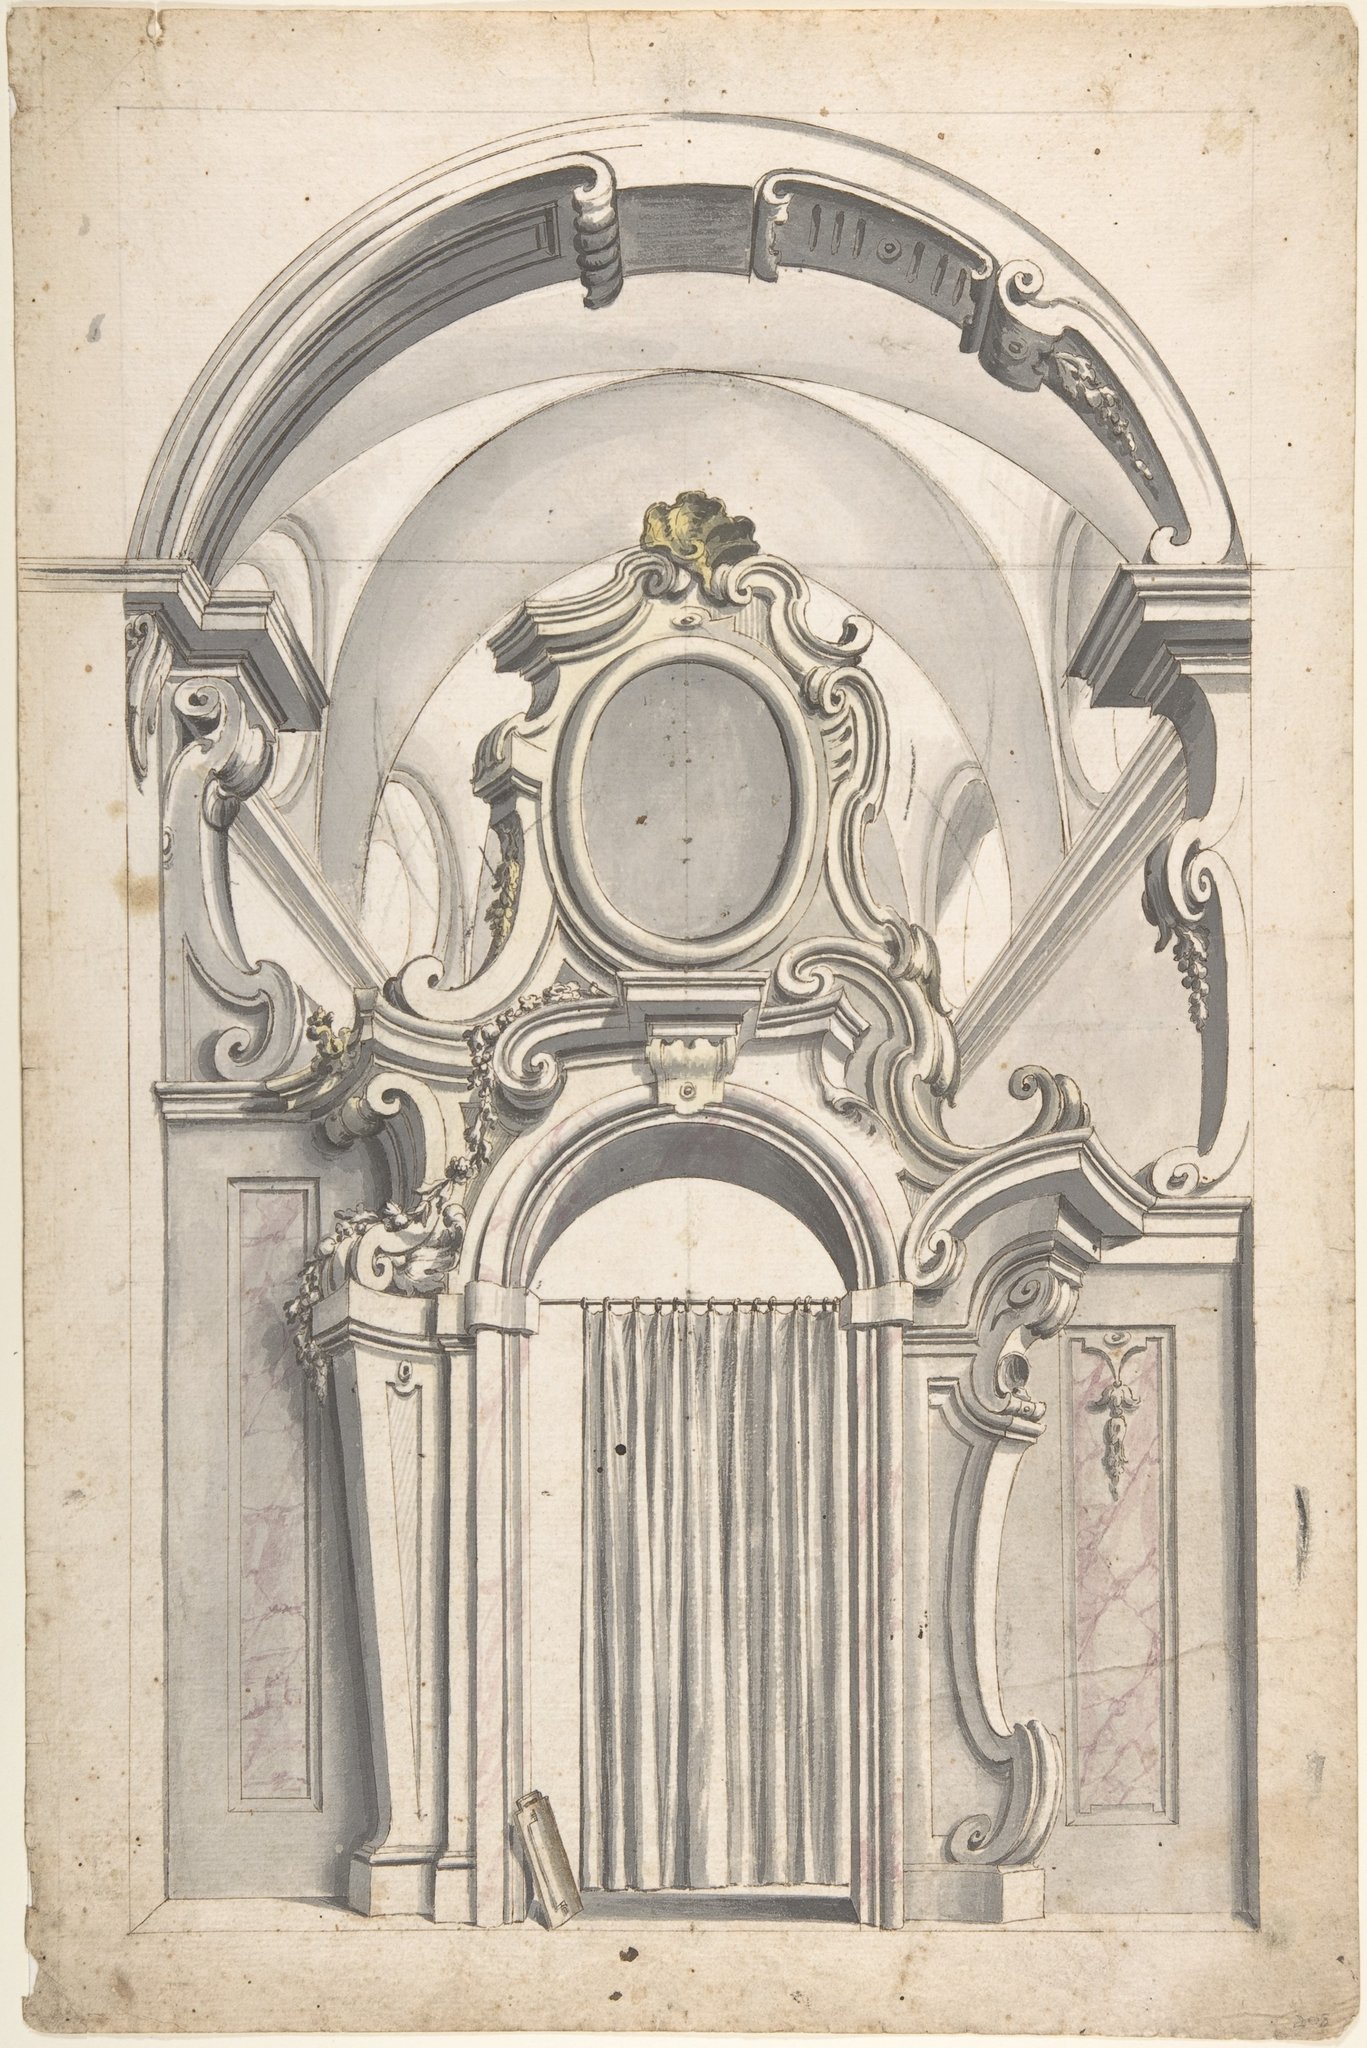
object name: drawing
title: Design for an Elaborate Doorway with a Vaulted Ceiling Behind, and a Curtain Drawn Across the Opening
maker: anonymous, italian, piedmontese, 18th century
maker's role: artist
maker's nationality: italian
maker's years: 1700-1800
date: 1700-1780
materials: graphite, ink, lead, drawing material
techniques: brush, pen, wash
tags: doorways,curtains